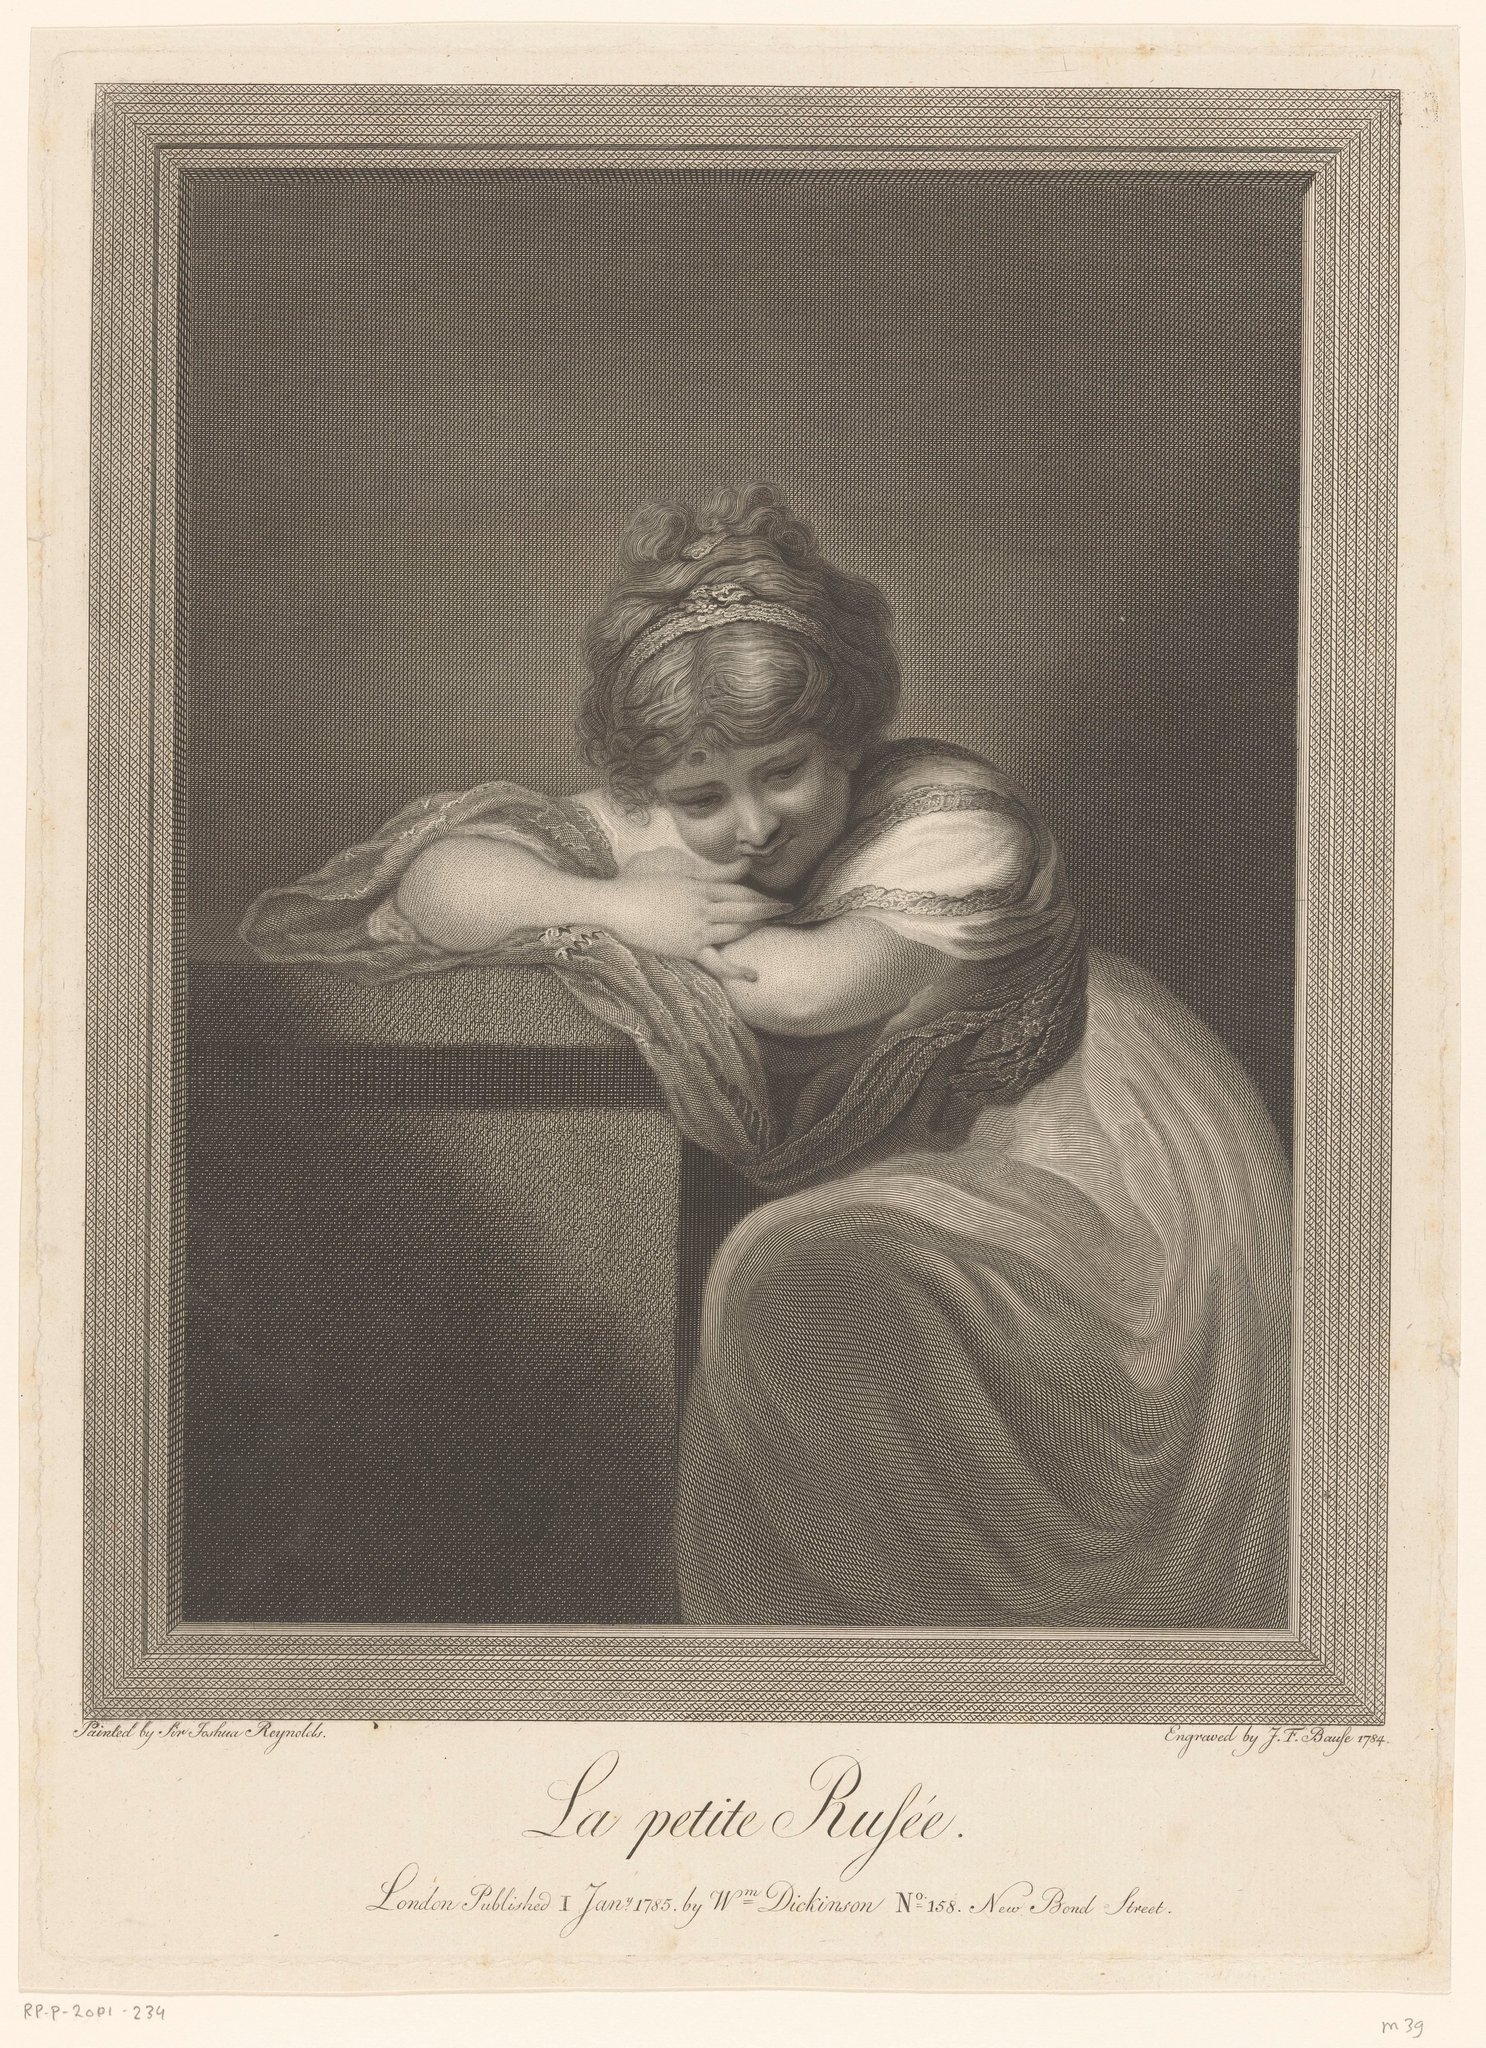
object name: print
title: La petite Rusée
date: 1785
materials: paper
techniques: engraving, etching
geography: leipzig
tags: girl (child between toddler and youth)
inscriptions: collector's mark: Lugt 2228, collector's mark: Lugt 2760